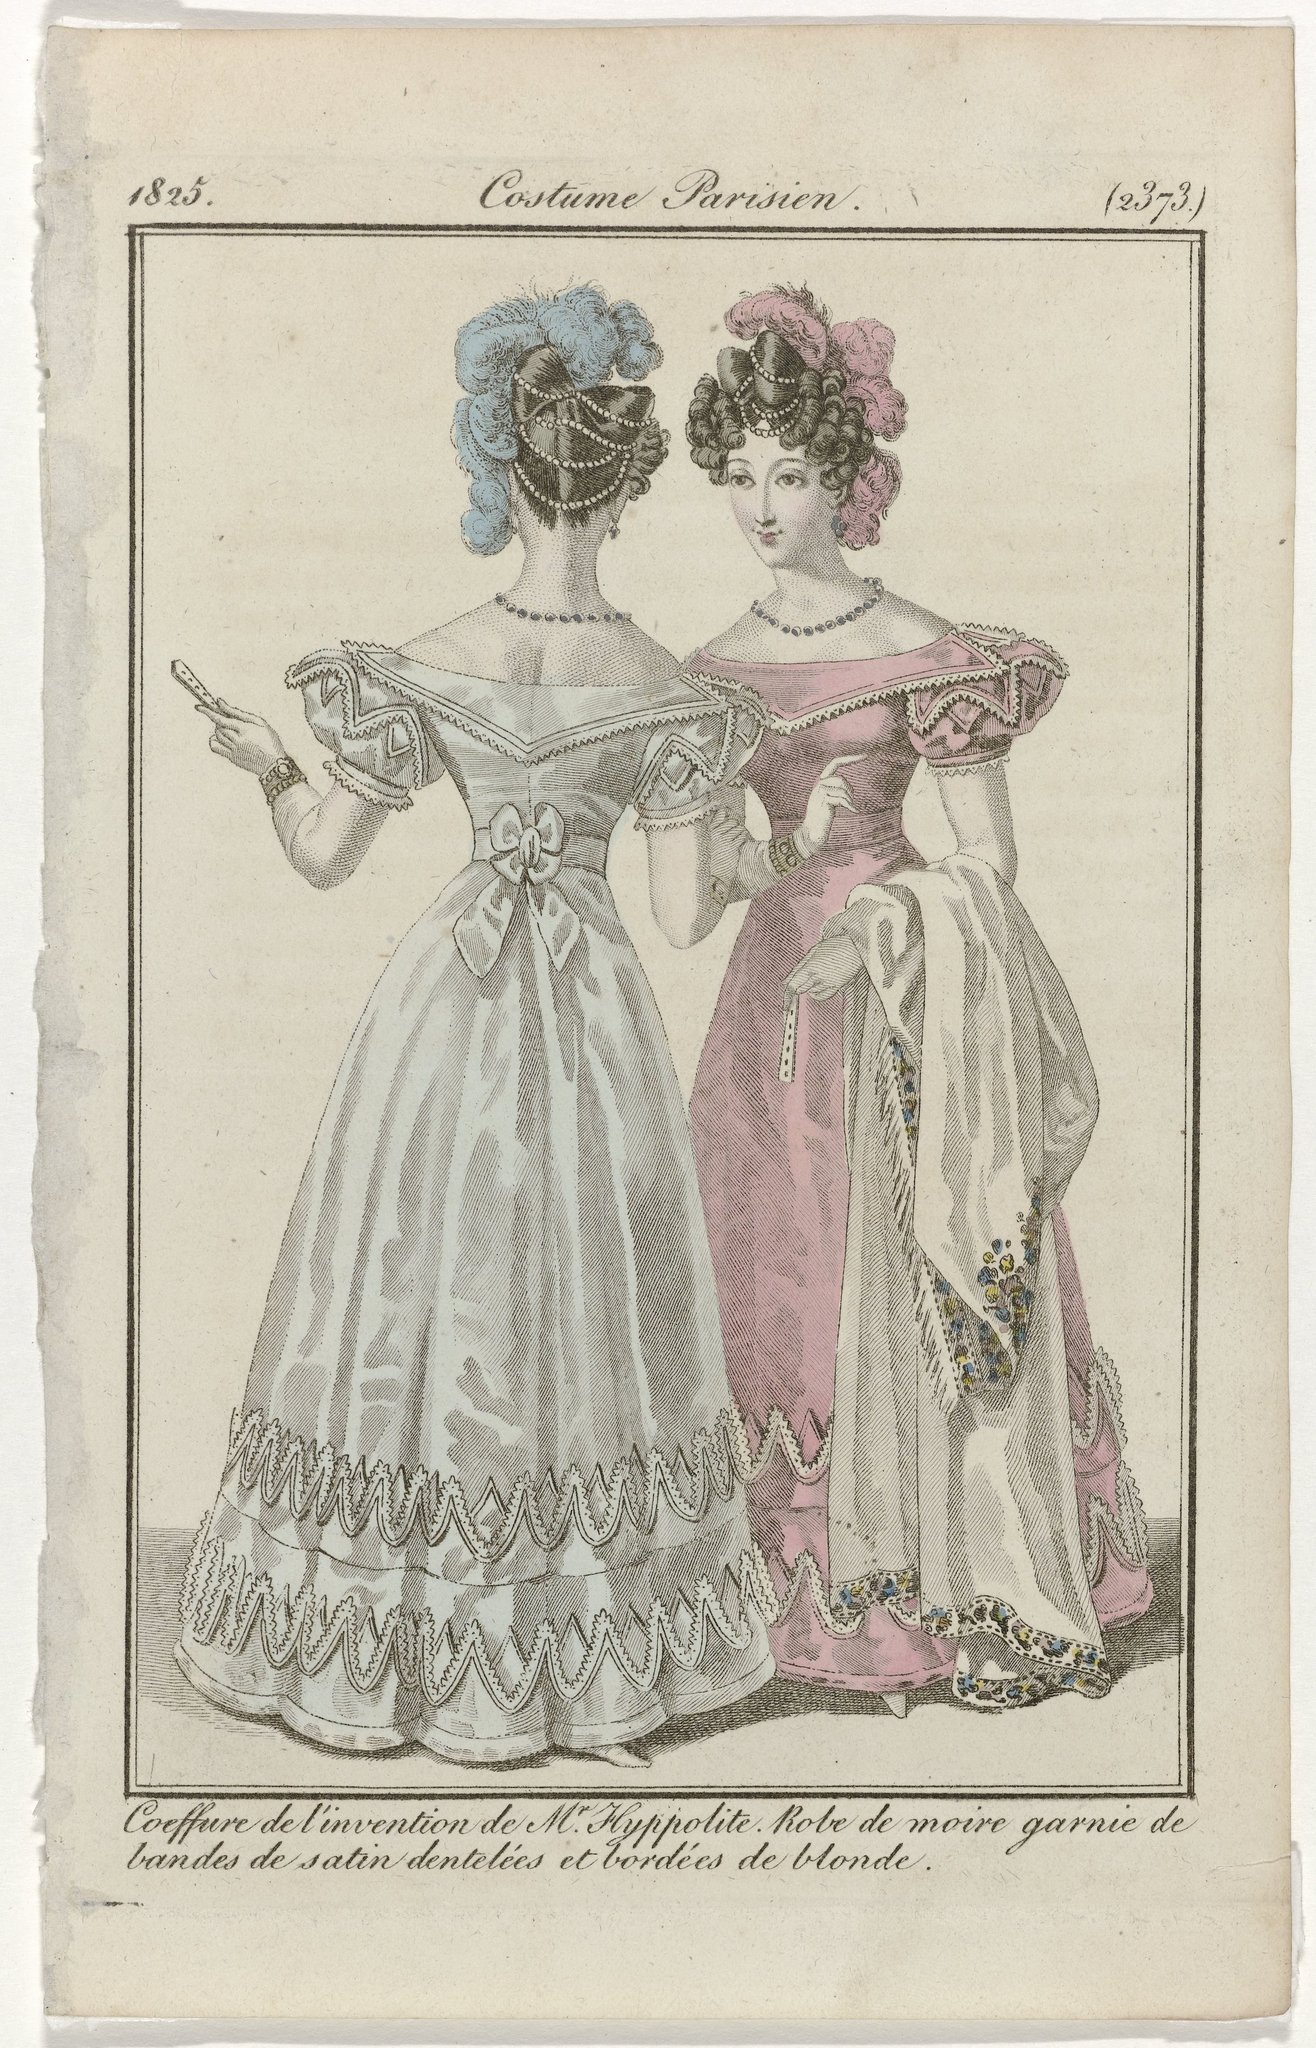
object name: fashion print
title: Journal des Dames et des Modes, Costume Parisien, 31 décembre 1825, (2373): Coeffure de l'invention (...)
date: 1825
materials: paper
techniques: engraving, hand coloring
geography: paris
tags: ear-rings (+ women's clothes), clothing for the upper part of the body (shawl) (+ women's clothes), ornamental parts of clothing (+ women's clothes), styles of hairdress - aa - ~ women, fashion plates, gloves, mittens, etc. (+ women's clothes), dress, gown (+ women's clothes), fan (+ women's clothes), bracelet, wristlet (+ women's clothes), necklace (+ women's clothes)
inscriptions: title: ‘Costume Parisien.’, caption: ‘Coeffure de l'invention de Mr. Hyppolite. Robe de moire garnie de bandes de satin dentelées et bordées de blonde.’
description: Twee vrouwen, van wie één op de rug gezien, in eenzelfde japon. Japon van 'moire' versierd met gekartelde banden van satijn afgezet met Blonde (kloskant). Korte pofmouwen. 'Coeffure' ontworpen door Mr Hyppolite. Accessoires: oorbellen, collier, waaier, handschoenen, armbanden om beide polsen, sjaal afgezet met franjes. De prent maakt deel uit van het modetijdschrift Journal des Dames et des Modes, uitgegeven door Pierre de la Mésangère, Parijs, 1797-1839.